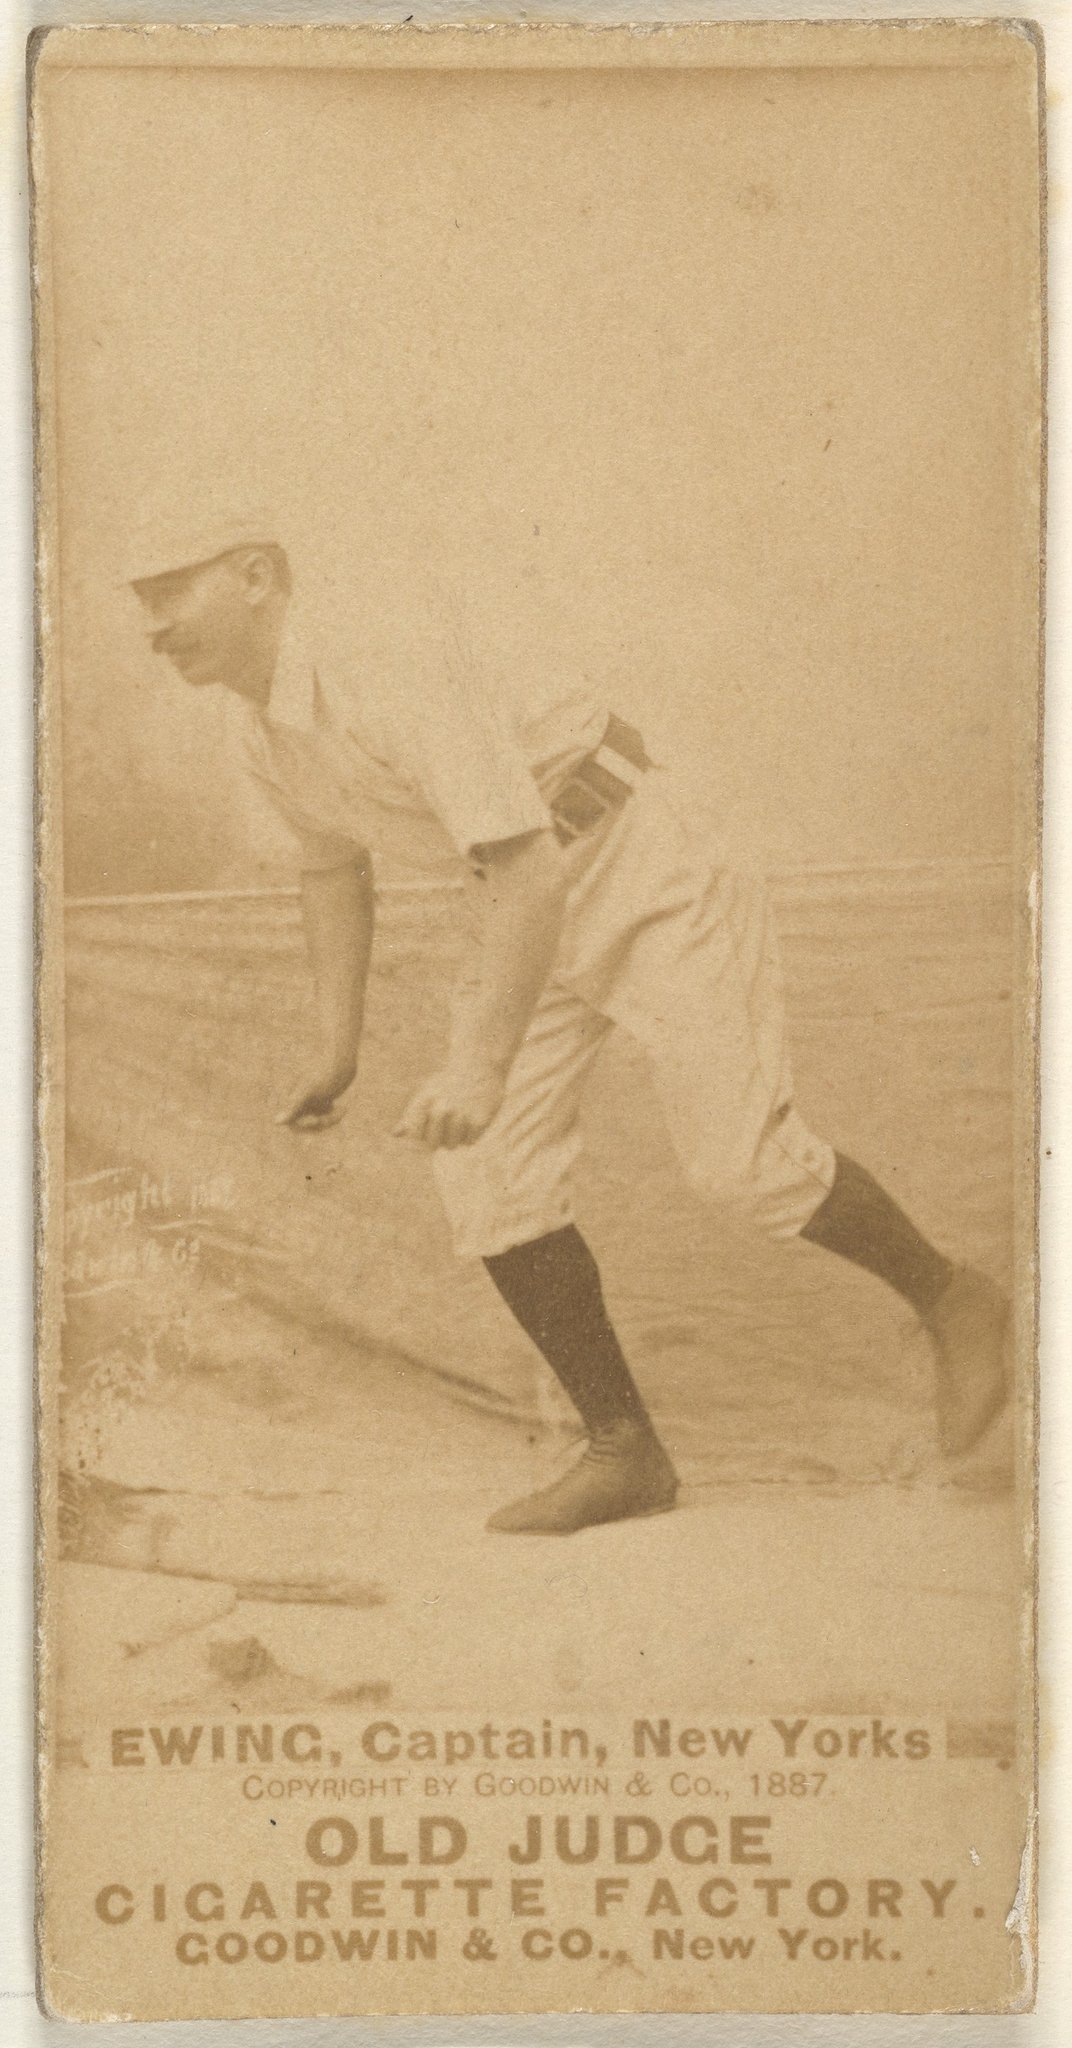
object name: baseball card, photograph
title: William "Buck" Ewing, Captain and Catcher, New York, from the Old Judge series (N172) for Old Judge Cigarettes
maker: goodwin & company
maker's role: publisher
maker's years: 1850-1950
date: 1887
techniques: albumen silver print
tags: men,portraits,baseball,athletes